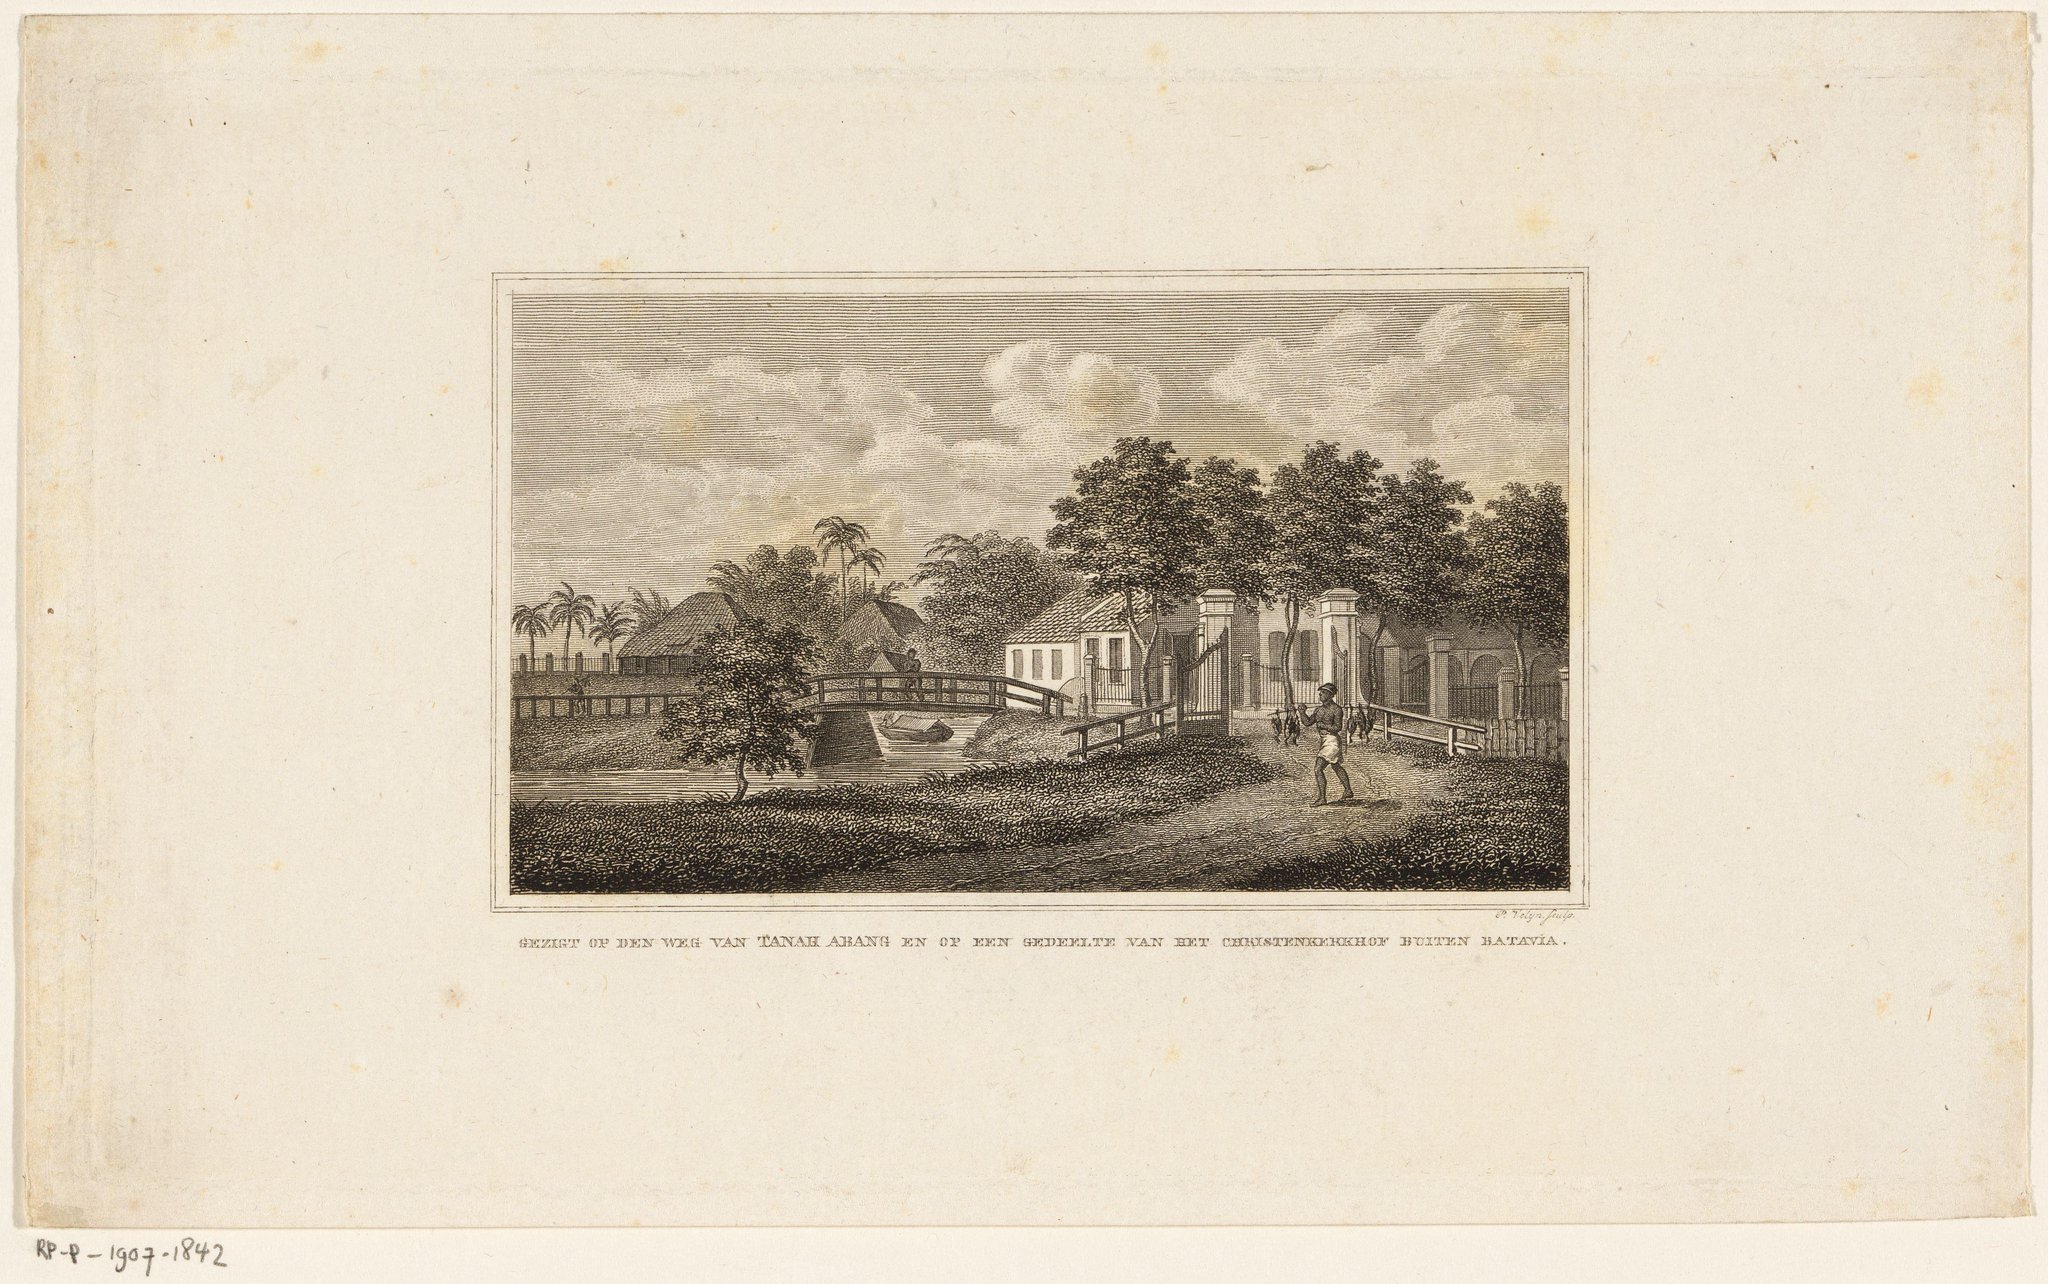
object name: print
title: Gezigt op den weg van Tanah Abang en op een gedeelte van het christenkerkhof buiten Batavia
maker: philippus velijn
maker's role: print maker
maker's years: 1787-1836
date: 1797-1836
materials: paper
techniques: etching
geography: netherlands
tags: landscape with bridge, viaduct or aqueduct, trees: palm-tree, fowling, fowler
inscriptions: collector's mark: Lugt 2228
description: Op een weg voor een huis loopt een man met een stok over zijn schouder waaraan gevogelte hangt. In het midden een houten brug waarop een figuur en links op de achtergrond palmbomen.